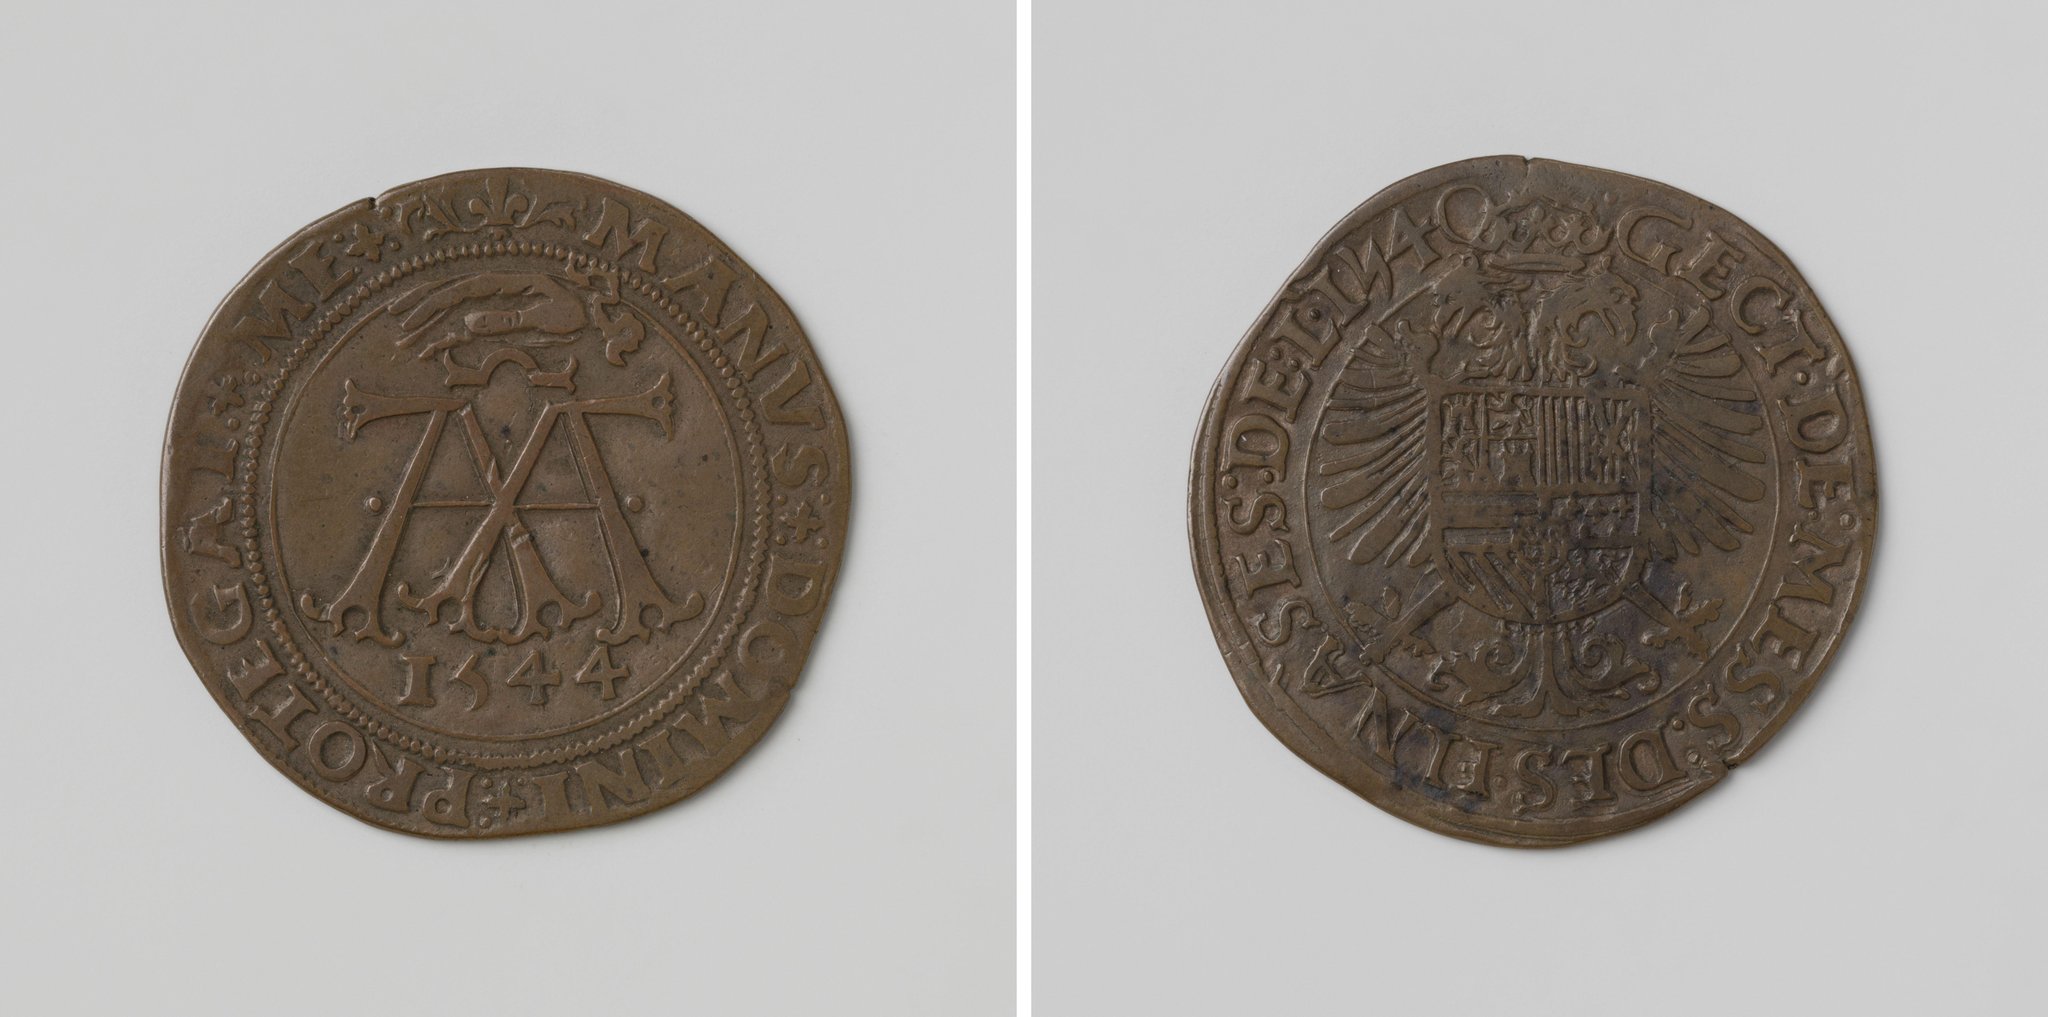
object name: jeton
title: Maria van Hongarije, landvoogdes der Nederlanden, rekenpenning van de raad van Financiën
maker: Anonymous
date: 1540-1544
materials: copper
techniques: striking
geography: netherlands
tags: brussels, maria van hongarije (landvoogdes der nederlanden)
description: Koperen penning. Voorzijde: letter M onder hand en accolade, boven jaartal binnen omschrift. Keerzijde: tweekoppige adelaar onder kroon houdt ruitvormig wapenschild voor zich binnen omschrift